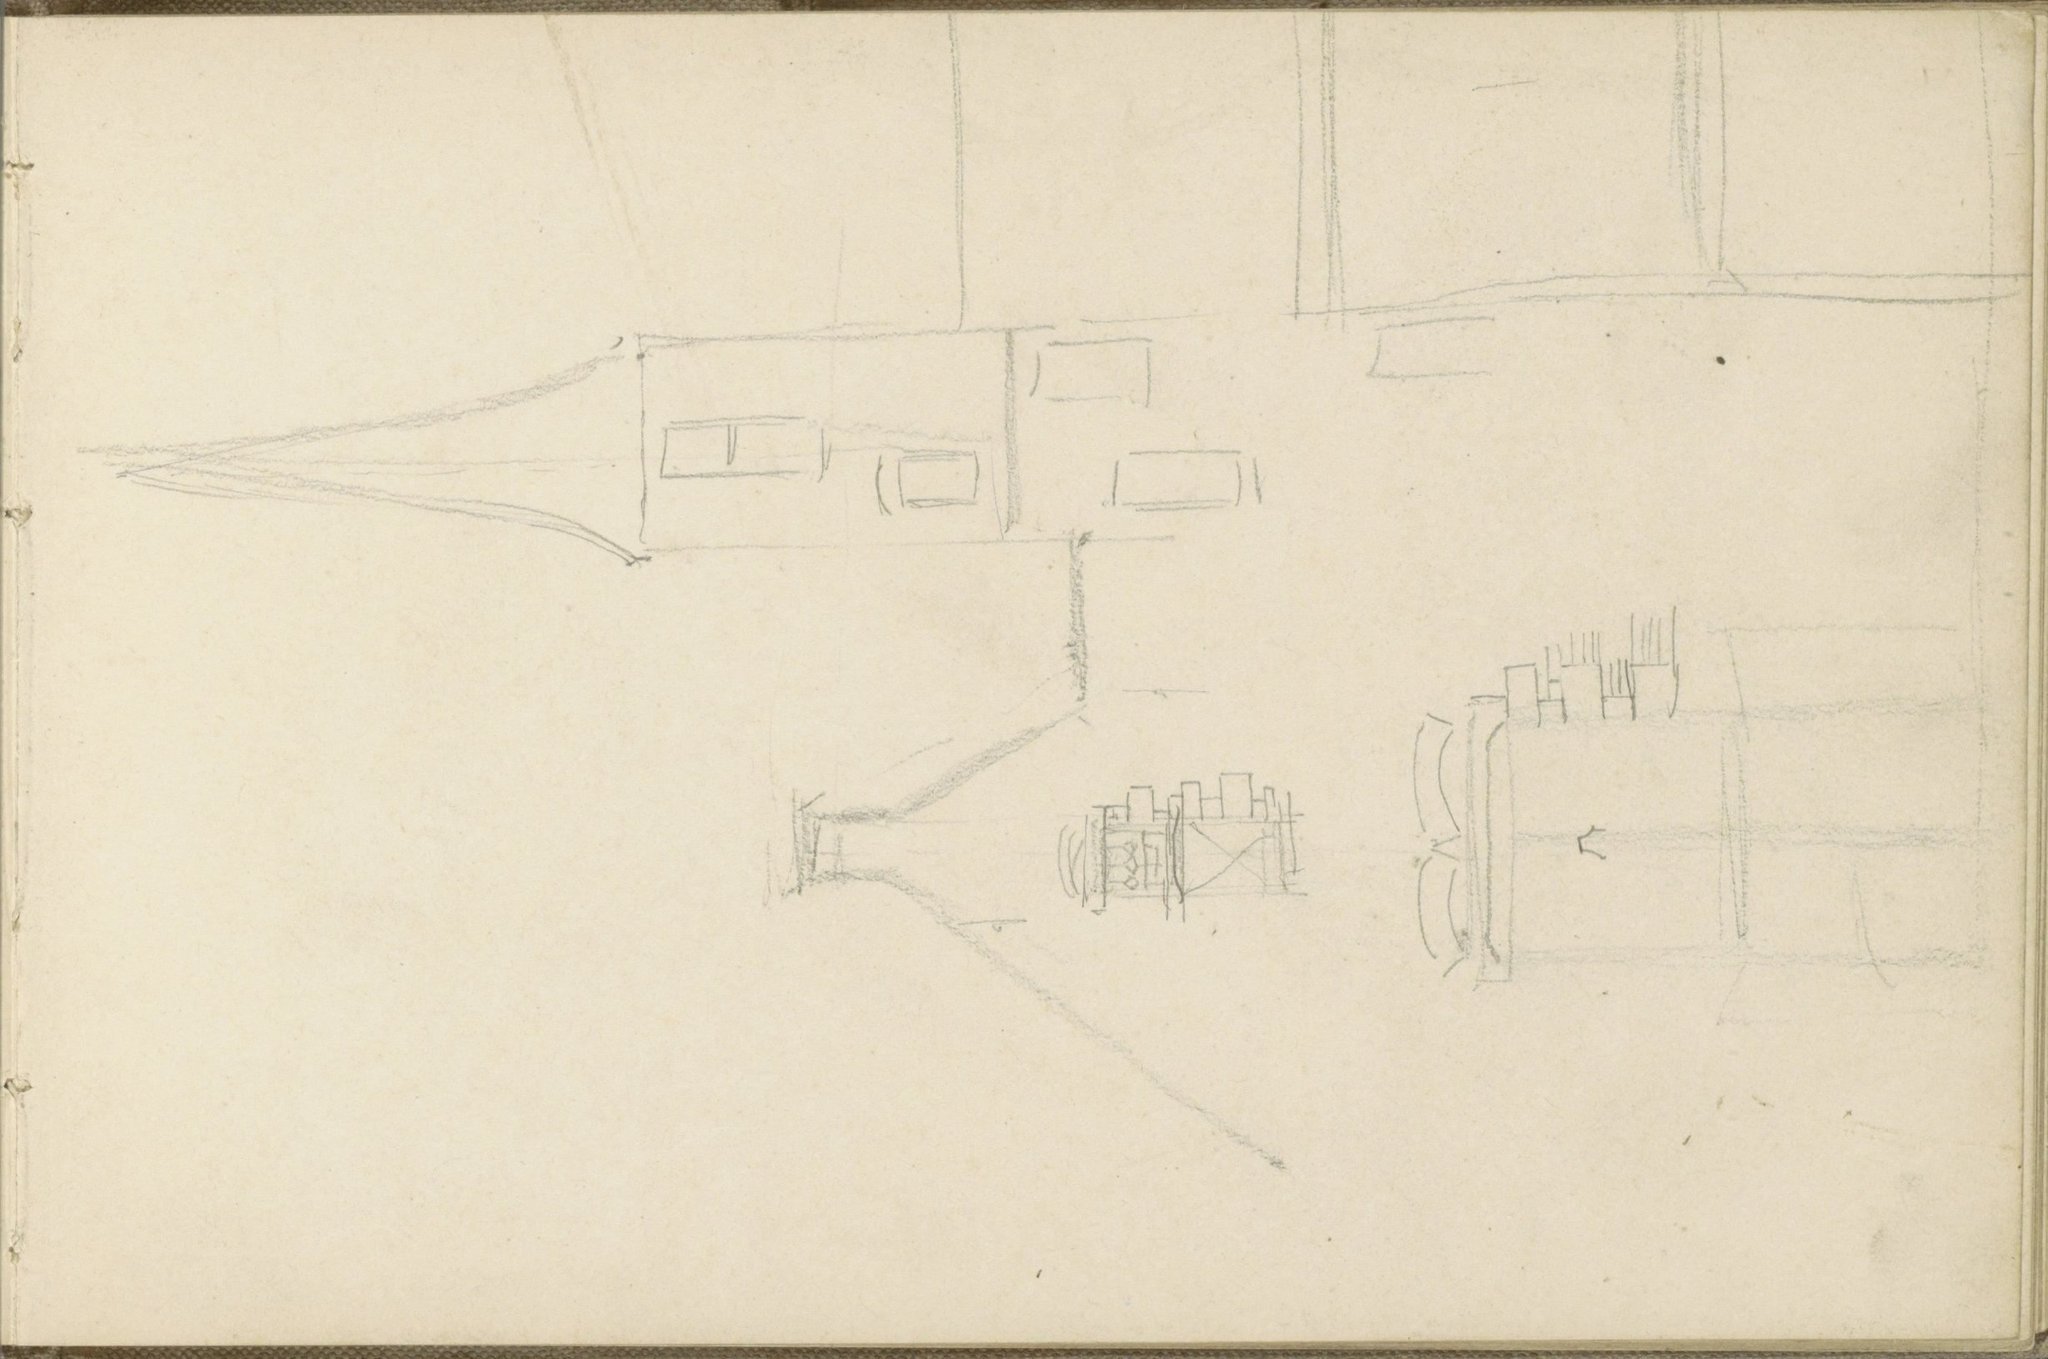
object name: sketchbook leaf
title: Rijtjeshuis met een tuitgevel en torenspits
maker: carel adolph lion cachet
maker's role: draughtsman, print maker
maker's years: 1864-1945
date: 1905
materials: paper, pencil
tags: façade (of house or building), tower (of house or building)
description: Blad 3 recto uit een schetsboek met 27 bladen.